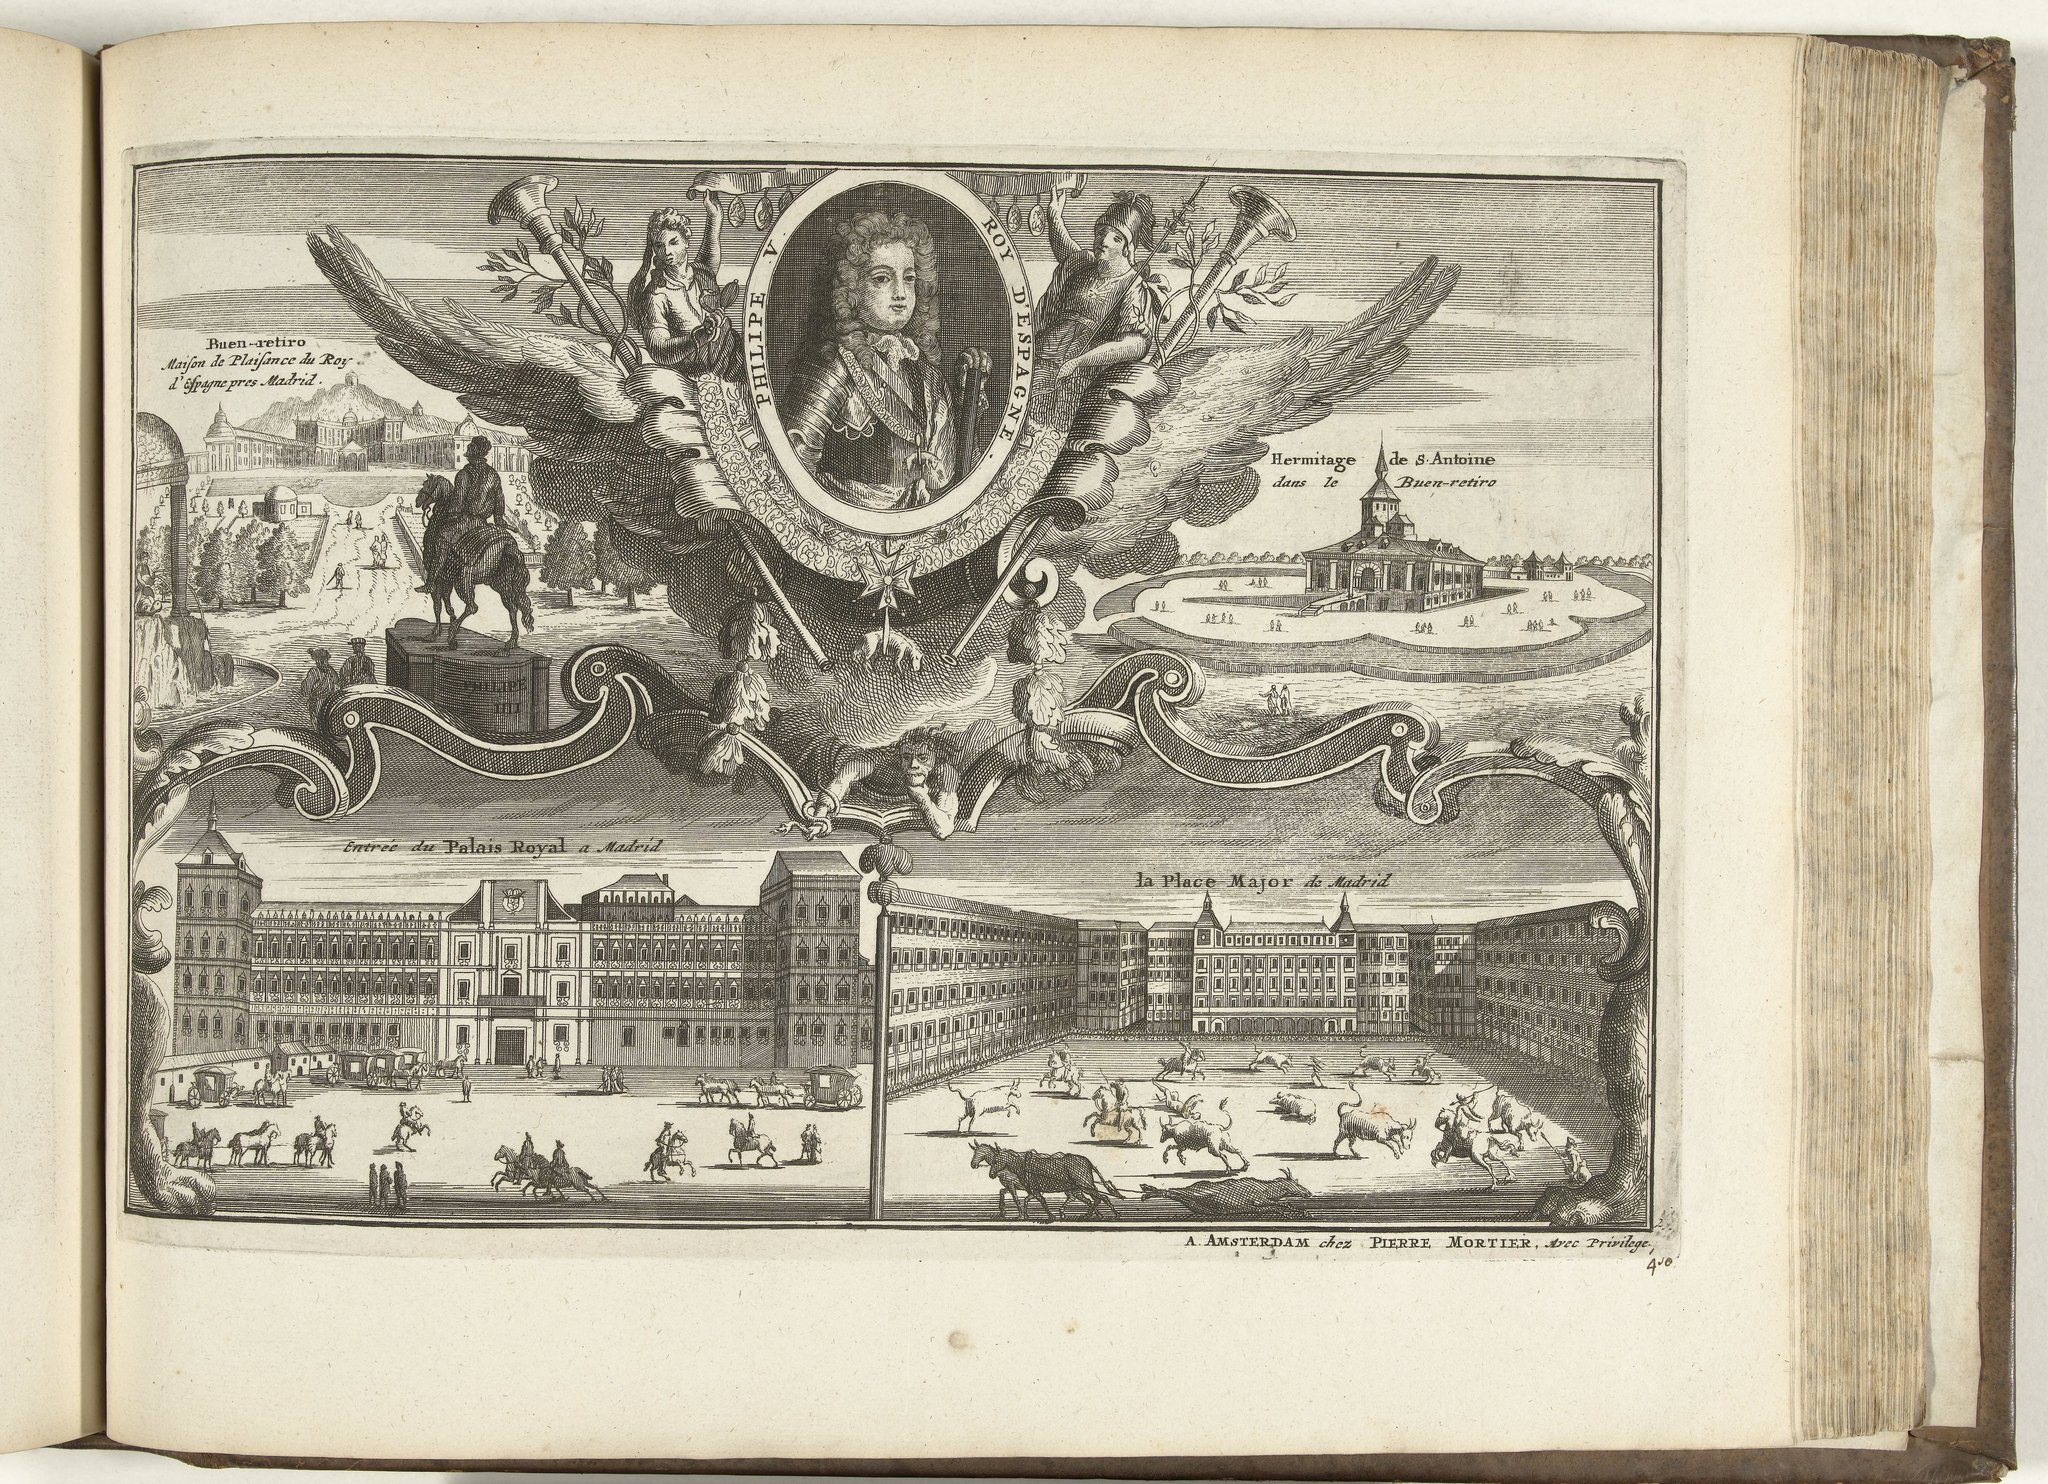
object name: print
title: Les Forces de l'Europe, Asie, Afrique et Amerique (...) Comme aussi les Cartes des Côtes de France et d'Espagne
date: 1726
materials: paper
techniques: etching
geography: northern netherlands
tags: filips v (koning van spanje), palace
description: Gezicht op het Koninklijk Paleis en enkele andere bezienswaardigheden te Madrid en een portret van koning Filips V. Plaat nr. 410 in deel XVII van het prentwerk: Les Forces de l'Europe, Asie, Afrique et Amerique ... Comme aussi les Cartes des Côtes de France et d'Espagne uit 1726, dit tweede deel met 271 met de hand genummerde platen van vermaarde sterke steden en vestingen in het kader van de Spaanse Successieoorlog 1701-1713. Voor het merendeel zijn deze platen gekopieerd naar de anonieme Franse platen van vermaarde sterke steden en vestingen: in Les forces de l'Europe en in: Le theatre de la guerre, dans les Pays-Bas, beide oorspronkelijk uitgegeven door Nicolas de Fer te Parijs (1693-1697) in het kader van de Negenjarige Oorlog. Rechtsonder sporen van het weggepolijste nummer: 259.